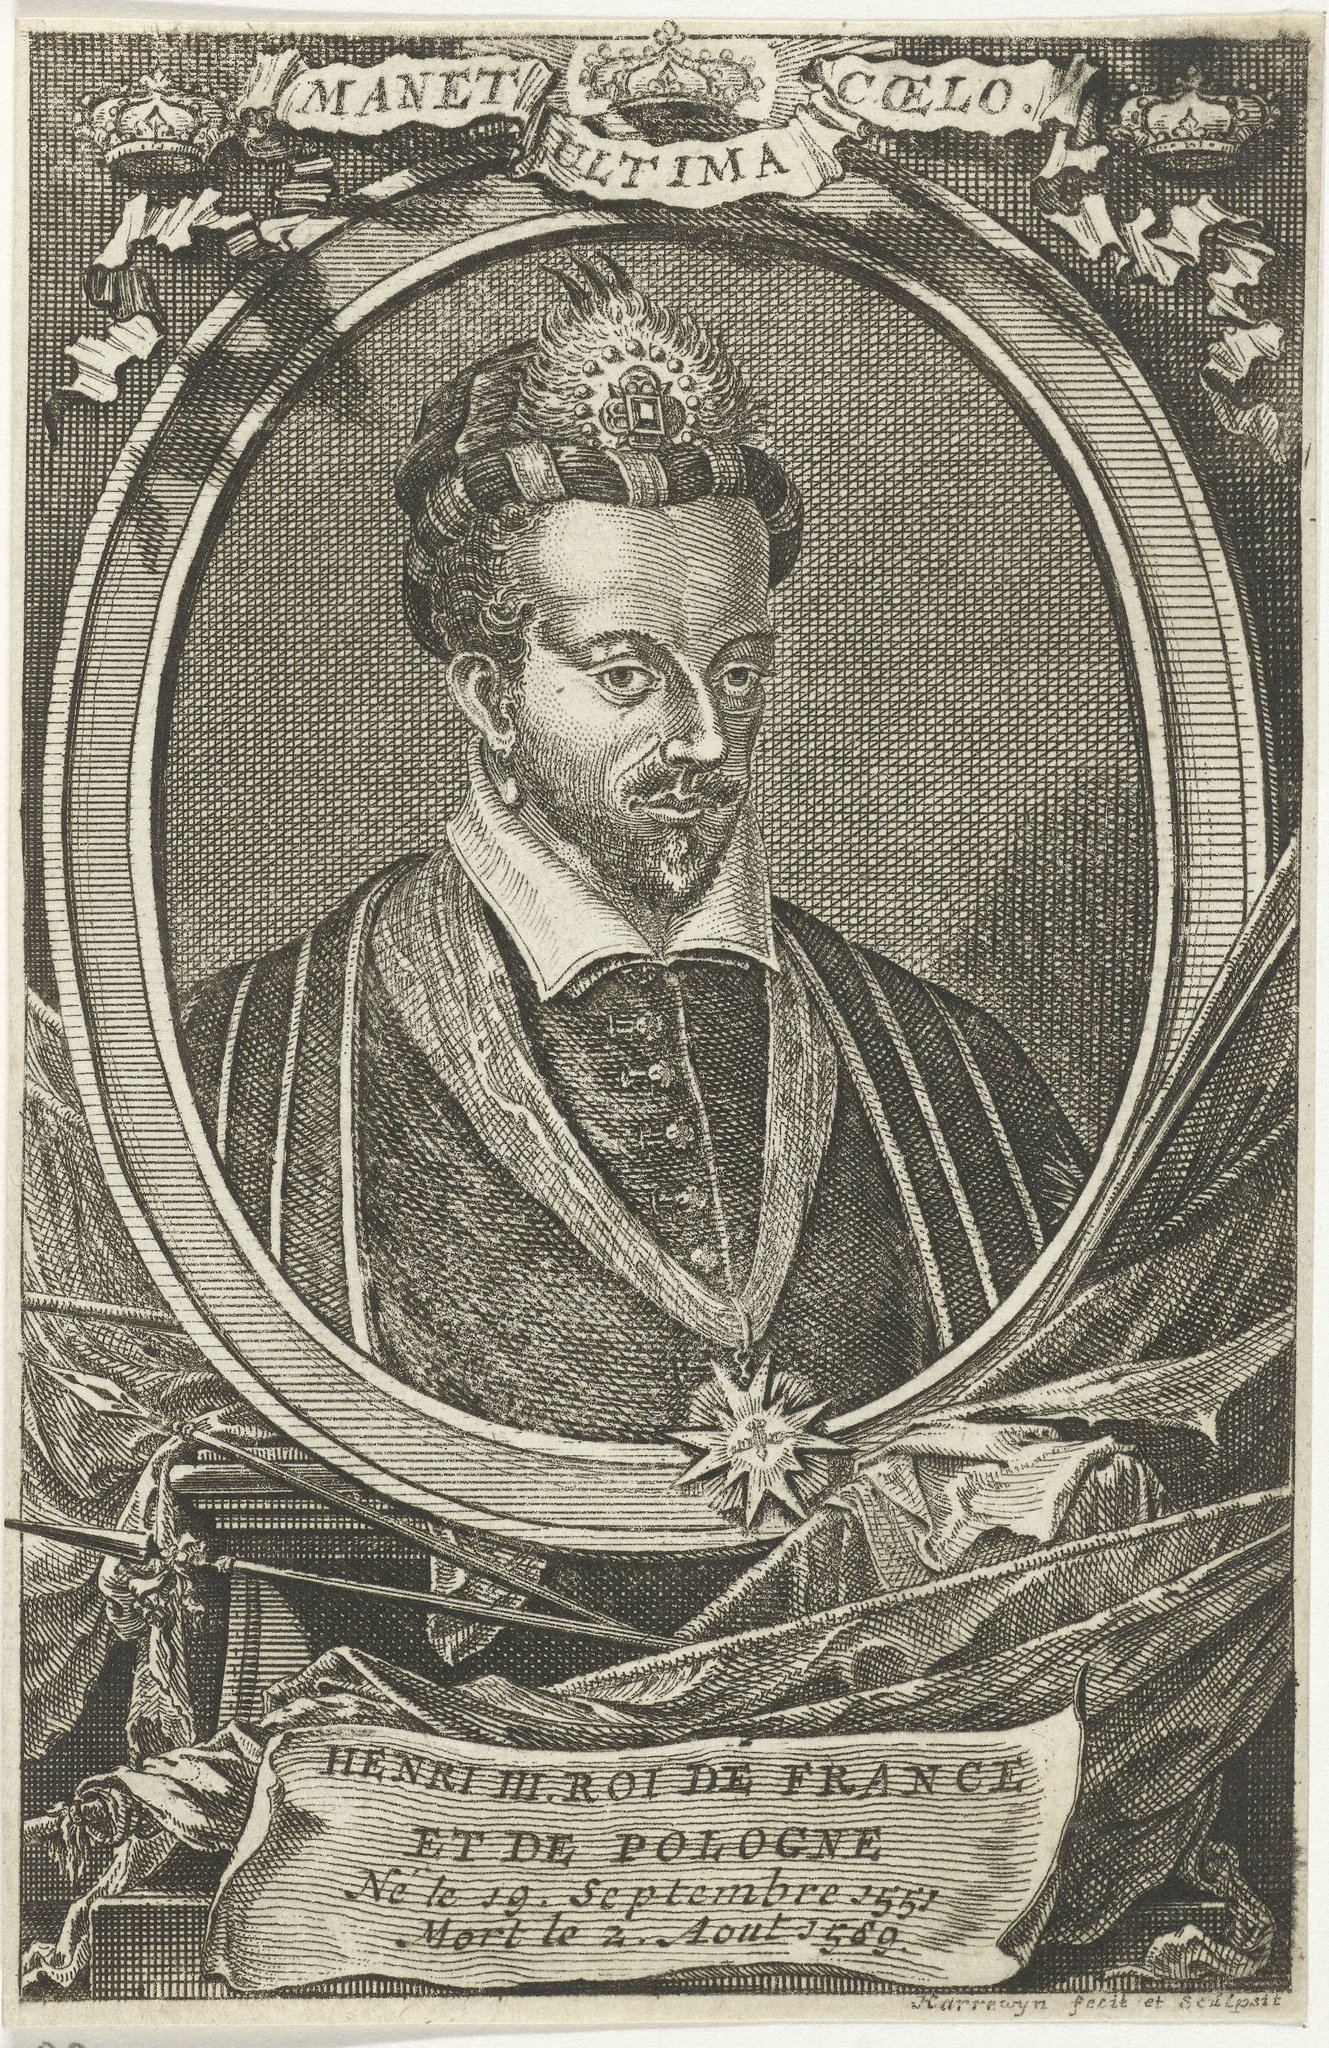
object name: print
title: Portret van Hendrik III, koning van Frankrijk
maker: jacobus harrewijn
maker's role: print maker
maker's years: 1660-1740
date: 1682-1730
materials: paper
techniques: engraving, etching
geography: low countries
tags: hendrik iii (koning van frankrijk)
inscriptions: collector's mark: Lugt 2228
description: Buste naar rechts van Hendrik III, koning van Frankrijk in een ovaal. Boven het portret een afbeelding van een kroon en de spreuk: Manet ultima coelo. Onder het portret vier regels in het Frans.